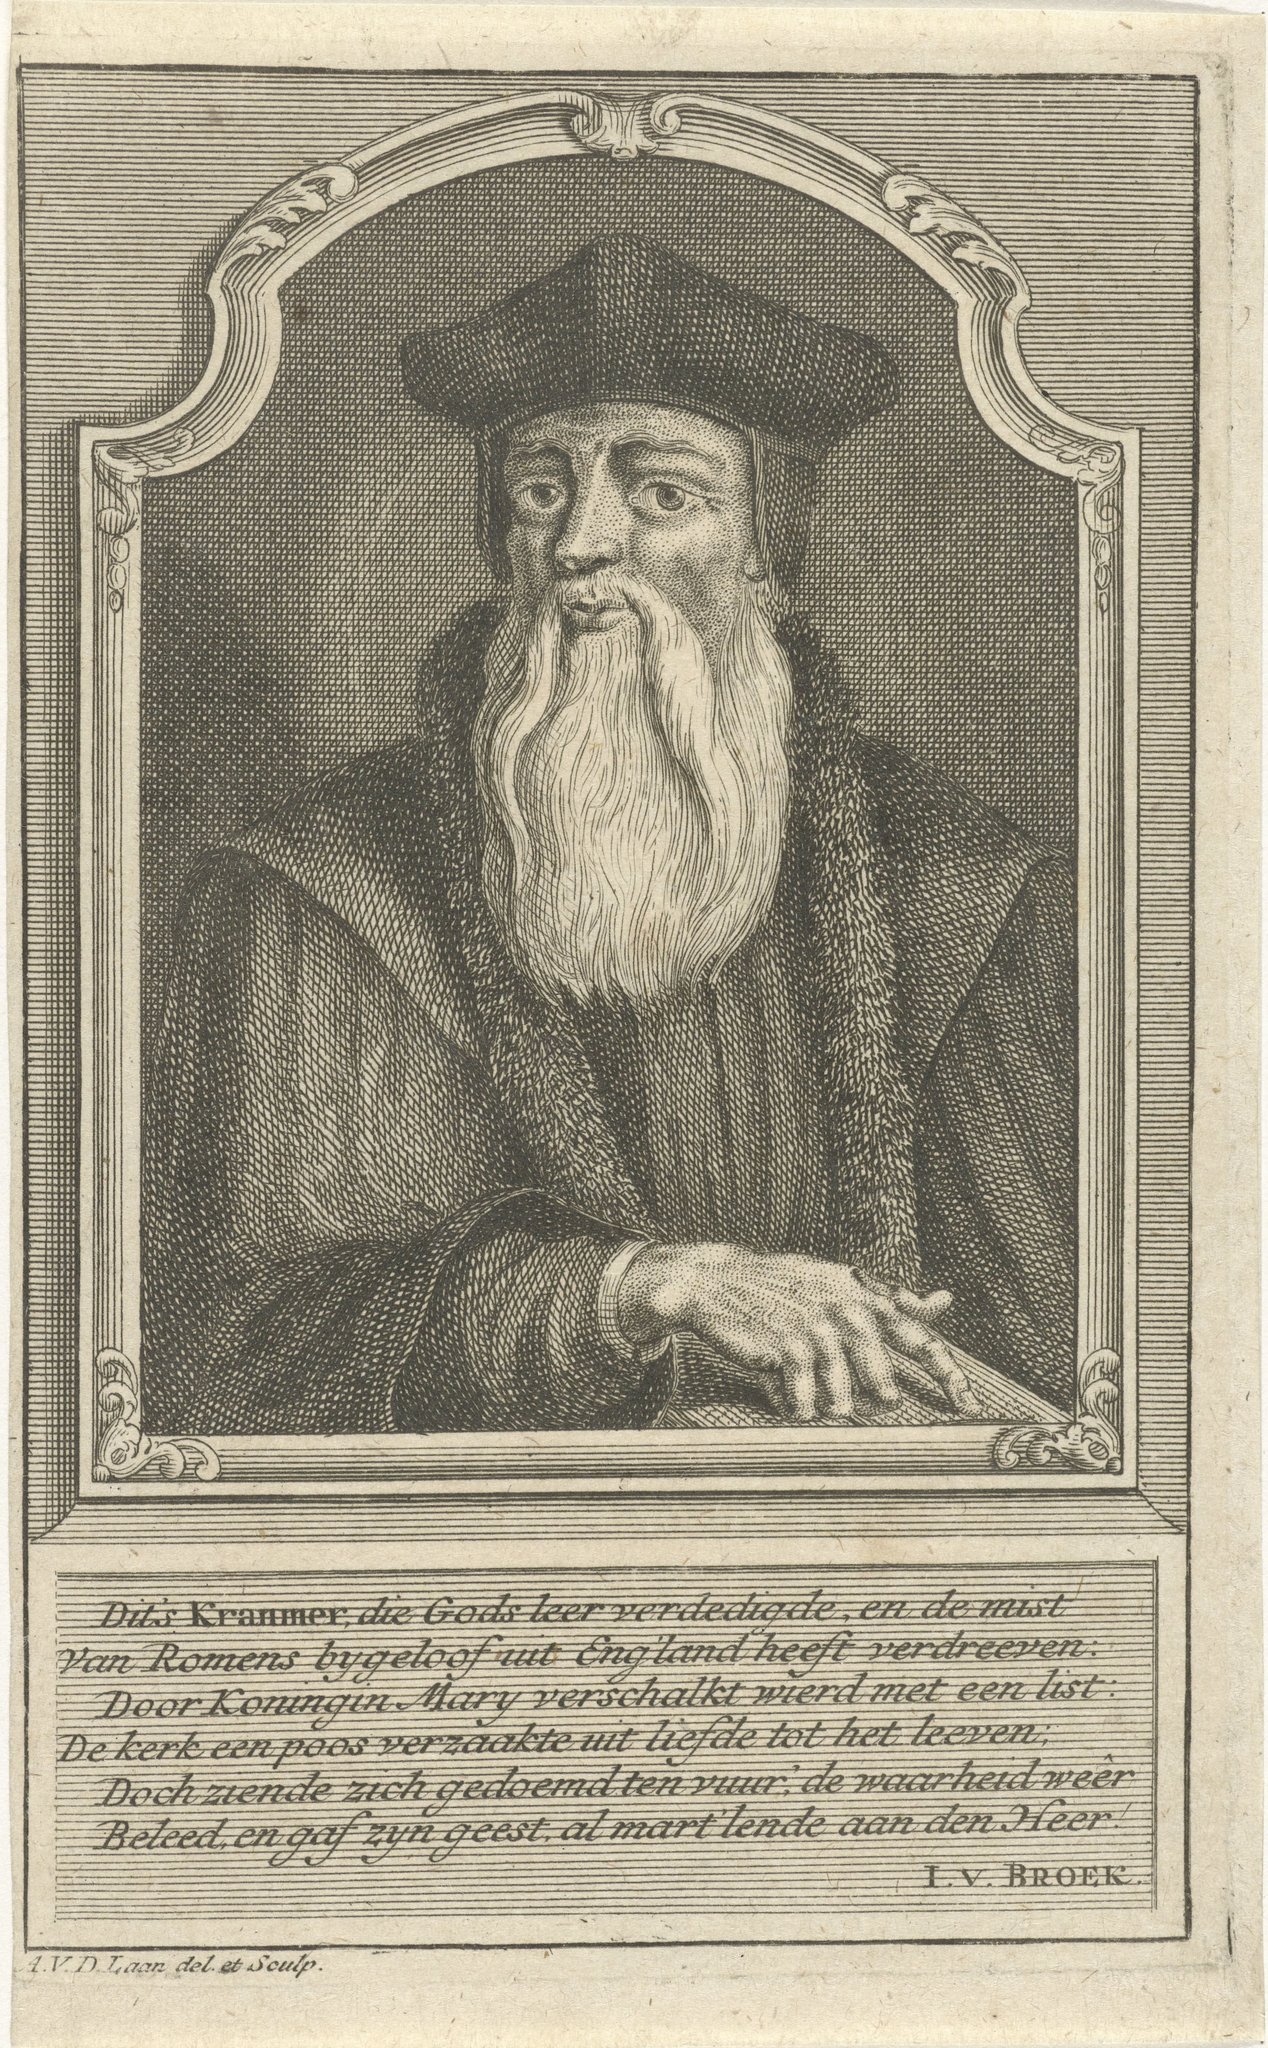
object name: print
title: Portret van Thomas Cranmer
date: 1694-1755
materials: paper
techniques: engraving, etching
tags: oxford, aartsbisschop, thomas cranmer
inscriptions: collector's mark: Lugt 2228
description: Portretbuste van voren van de aartsbisschop Thomas Cranmer, met baret en bontkraag. Rondom een toogvormige omlijsting, onder het portret een zesregelig Nederlands vers.